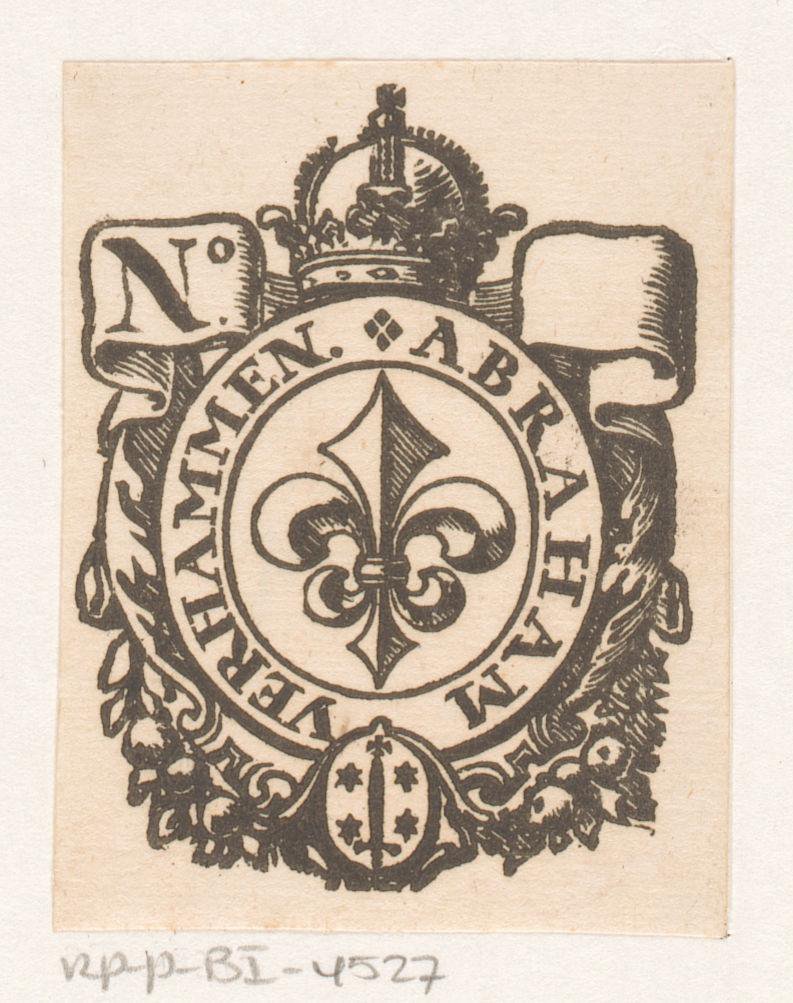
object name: print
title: Vignet van Abraham Verhammen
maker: Anonymous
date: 1600-1699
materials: paper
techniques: woodcut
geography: netherlands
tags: coat of arms (as symbol of the state, etc.), coat of arms (as symbol of the state, etc.) (+ city; municipal), vignette, haarlem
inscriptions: collector's mark: Lugt 240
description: Wapen in een ovaal met randschrift. Midden boven een kroon. Midden onder het wapen van de stad Haarlem.